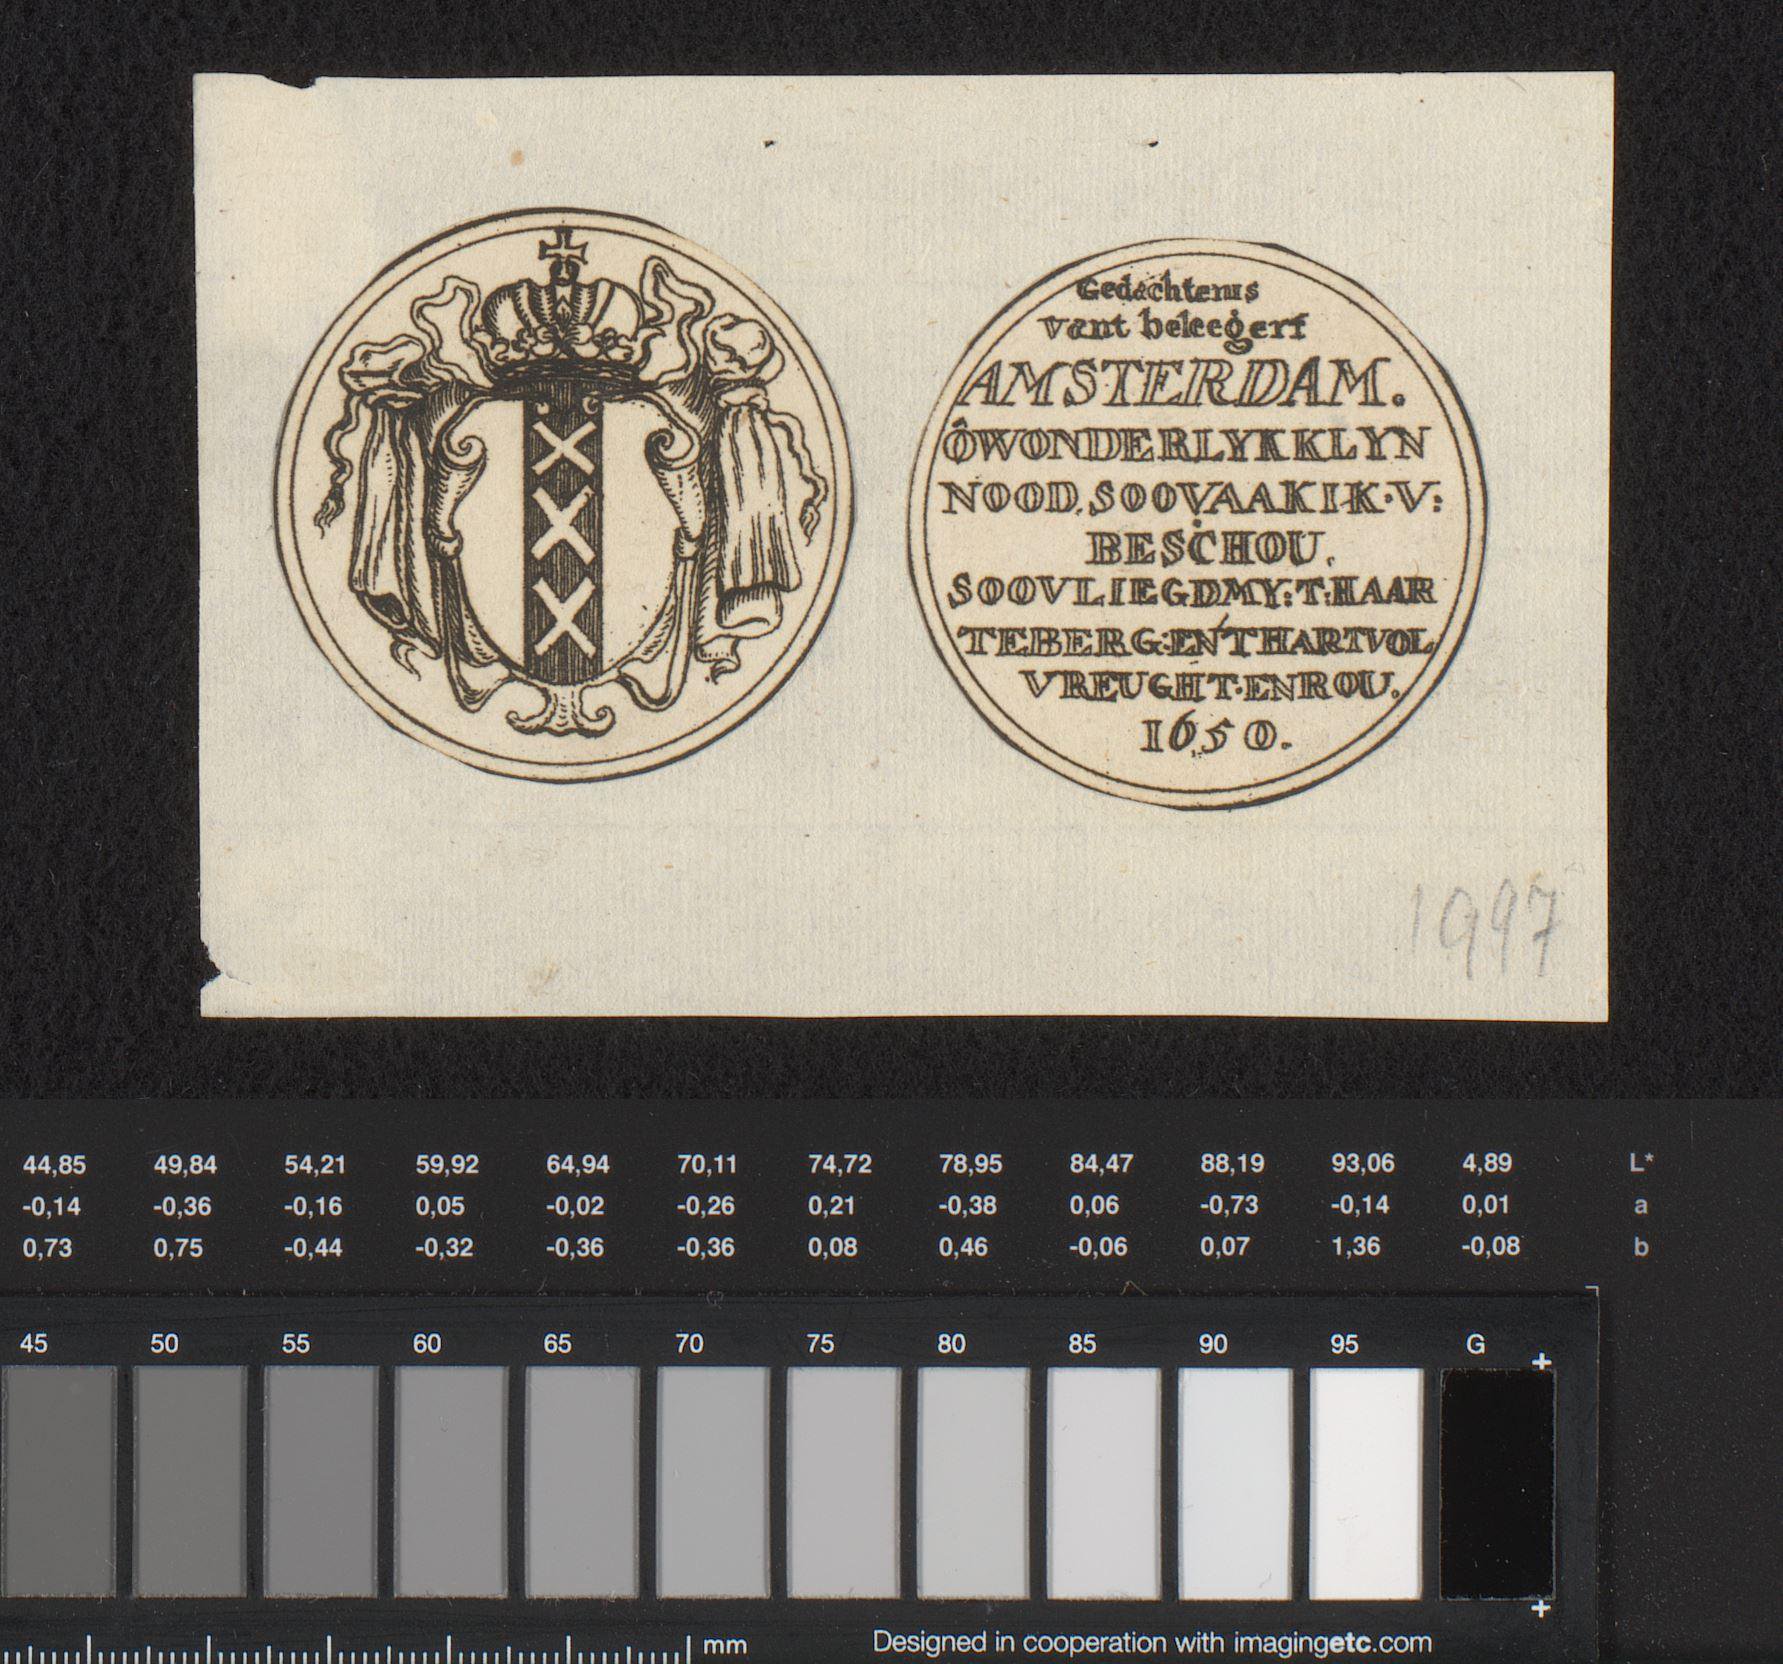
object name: print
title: Penning over het beleg van Amsterdam door Willem II, 1650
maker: Anonymous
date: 1724-1726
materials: paper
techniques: etching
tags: william ii (prince of orange), memorial medal, medal (considered as a piece of sculpture, regardless of its specific function), amsterdam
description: Prent uit: Gerard van Loon, Beschryving der Nederlandsche Historipenningen (...) sedert de overdracht der heerschappye van Keyzer Karel den Vden op Koning Philips (...) tot (...) den Uytrechtschen vreede. 4 dln. Den Haag: C. van Lom, 1723-1731, dl. II (1726), p. 344.